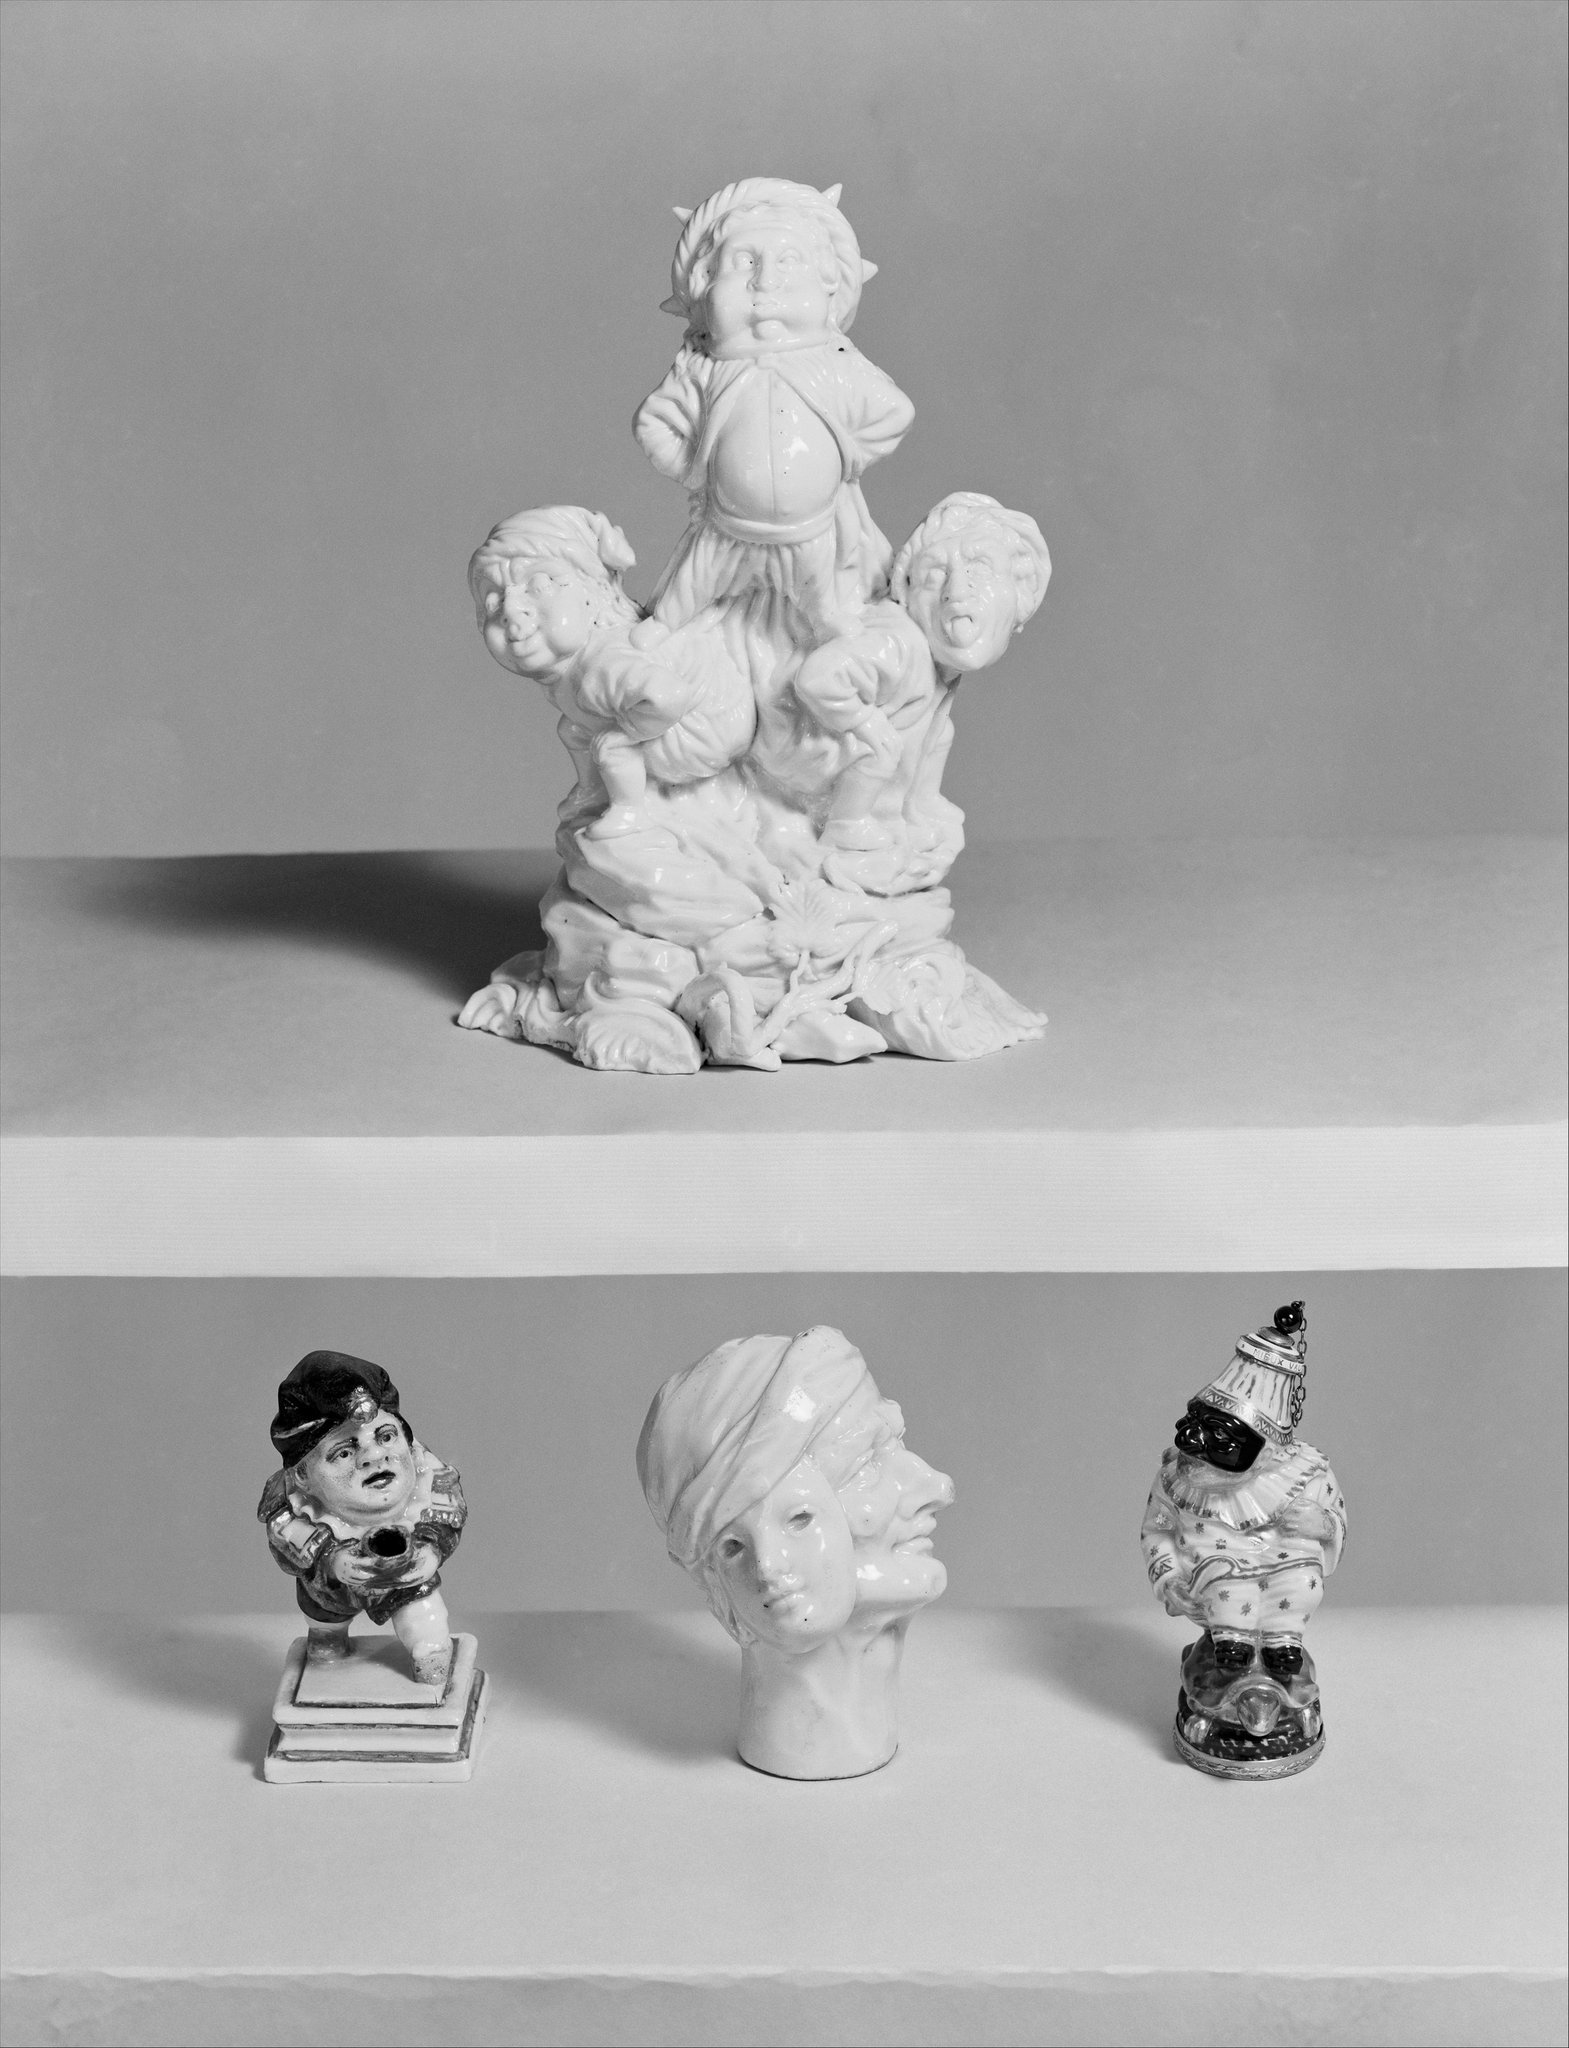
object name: group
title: Acrobats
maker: cozzi manufactory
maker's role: manufactory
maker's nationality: italian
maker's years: 1764-1812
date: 1765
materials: hard paste porcelain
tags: acrobats